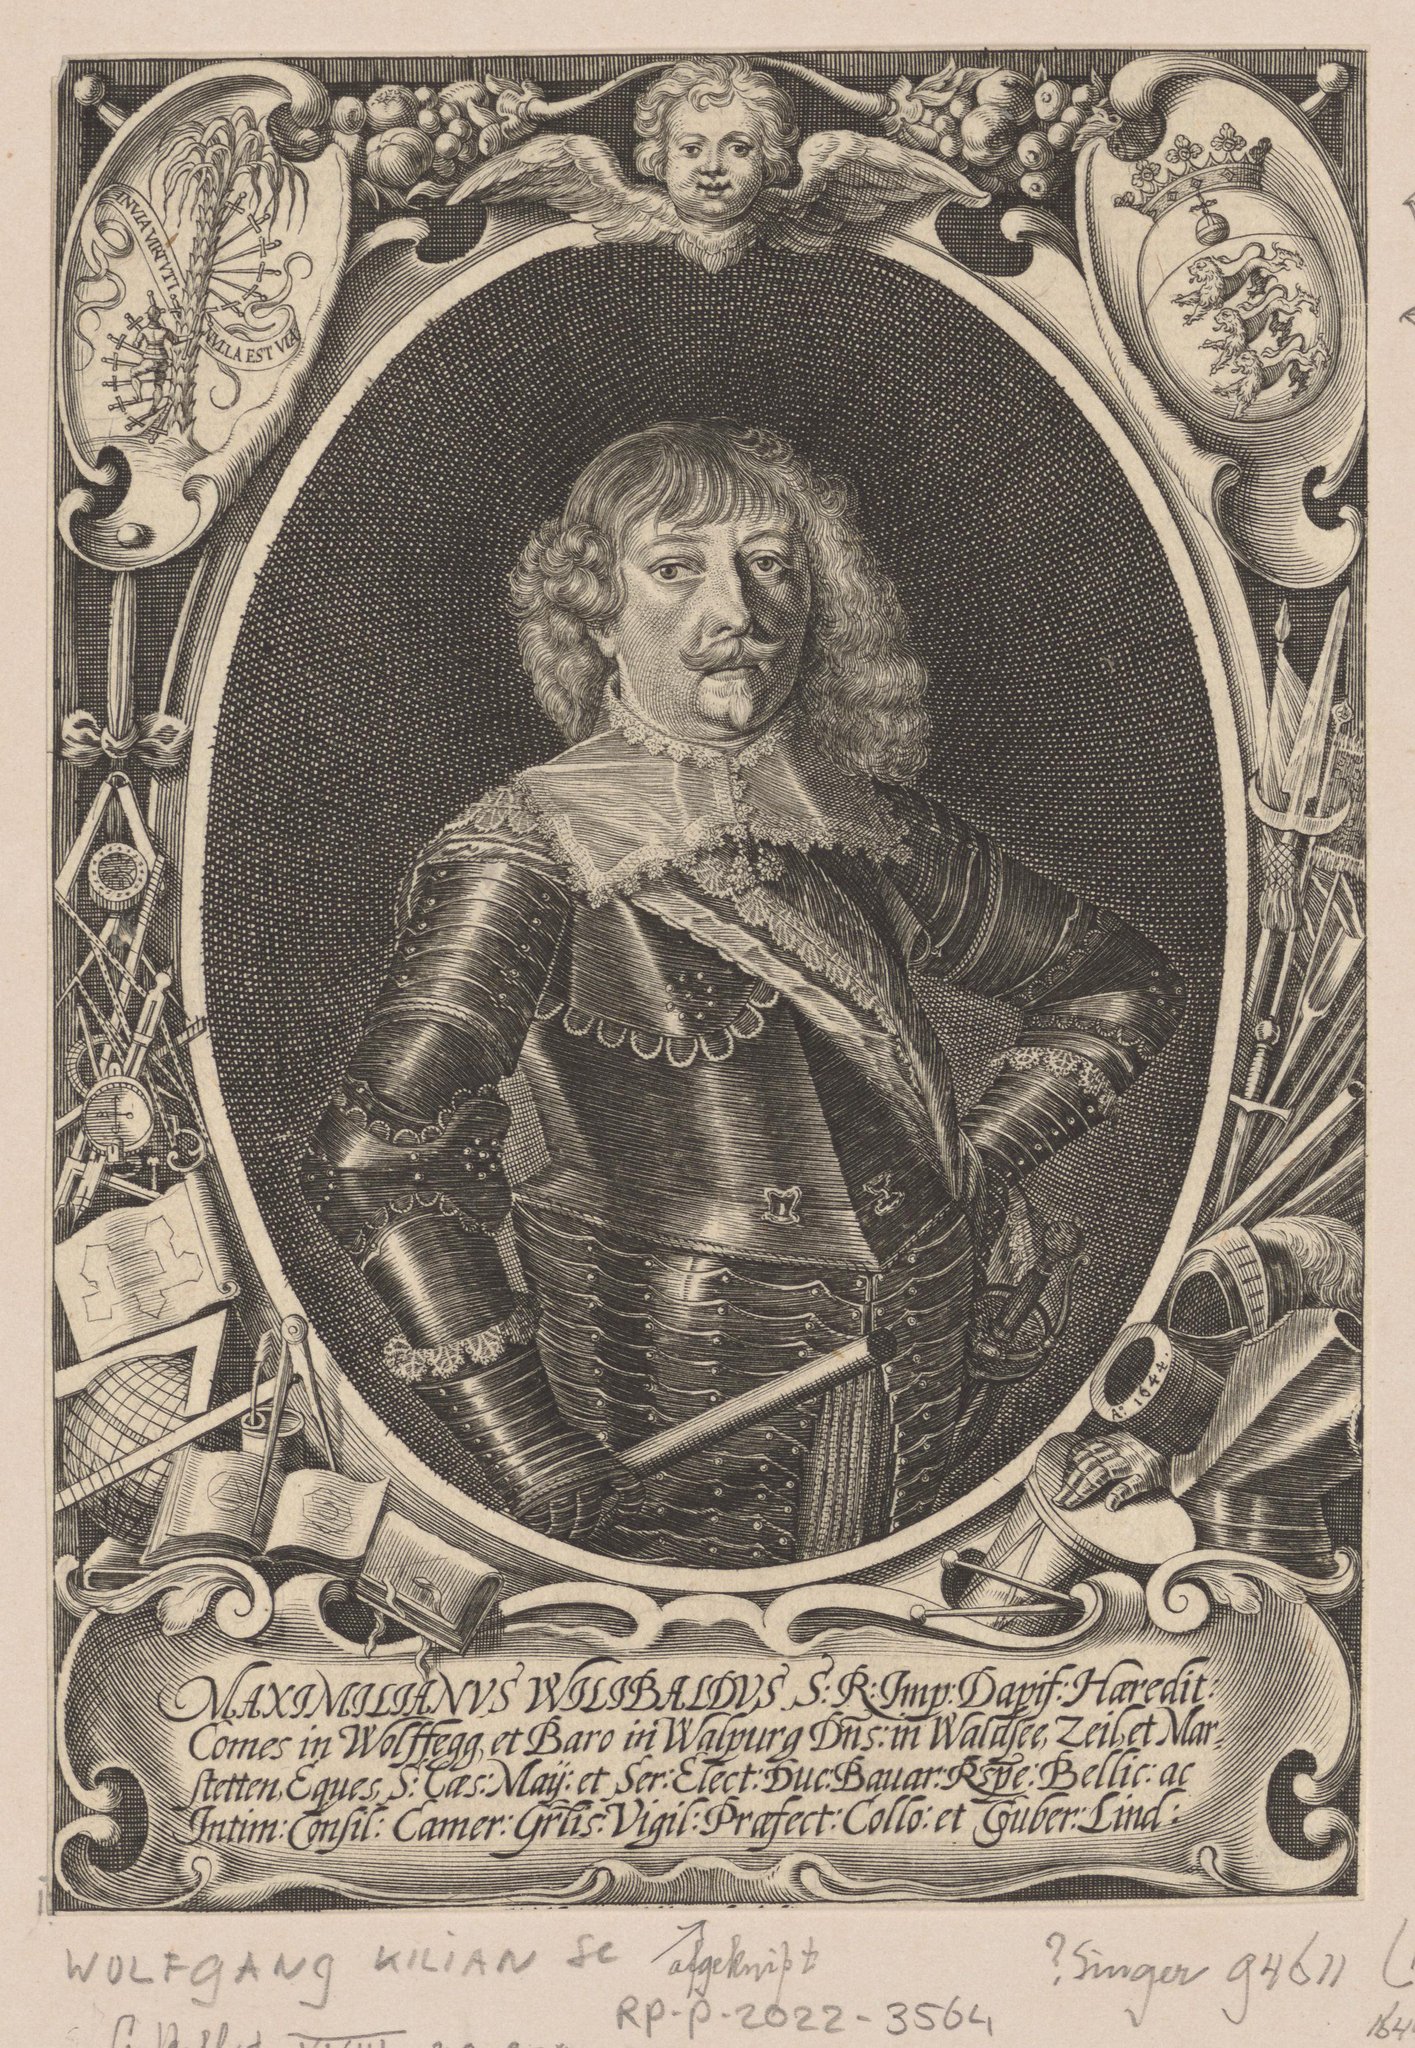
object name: print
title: Portret van Maximilian von Waldburg-Wolfegg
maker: wolfgang kilian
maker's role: print maker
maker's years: 1581-1662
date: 1644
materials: paper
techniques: engraving, etching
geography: augsburg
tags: amberg, earl, maximilian willibald von waldburg-wolfegg (graaf), 'tropaion', i.e. decorative ornament ~ weapons, writing tools, commander-in-chief, general, marshal, historical persons, ambassador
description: Met vierregelig onderschrift in het Latijn.